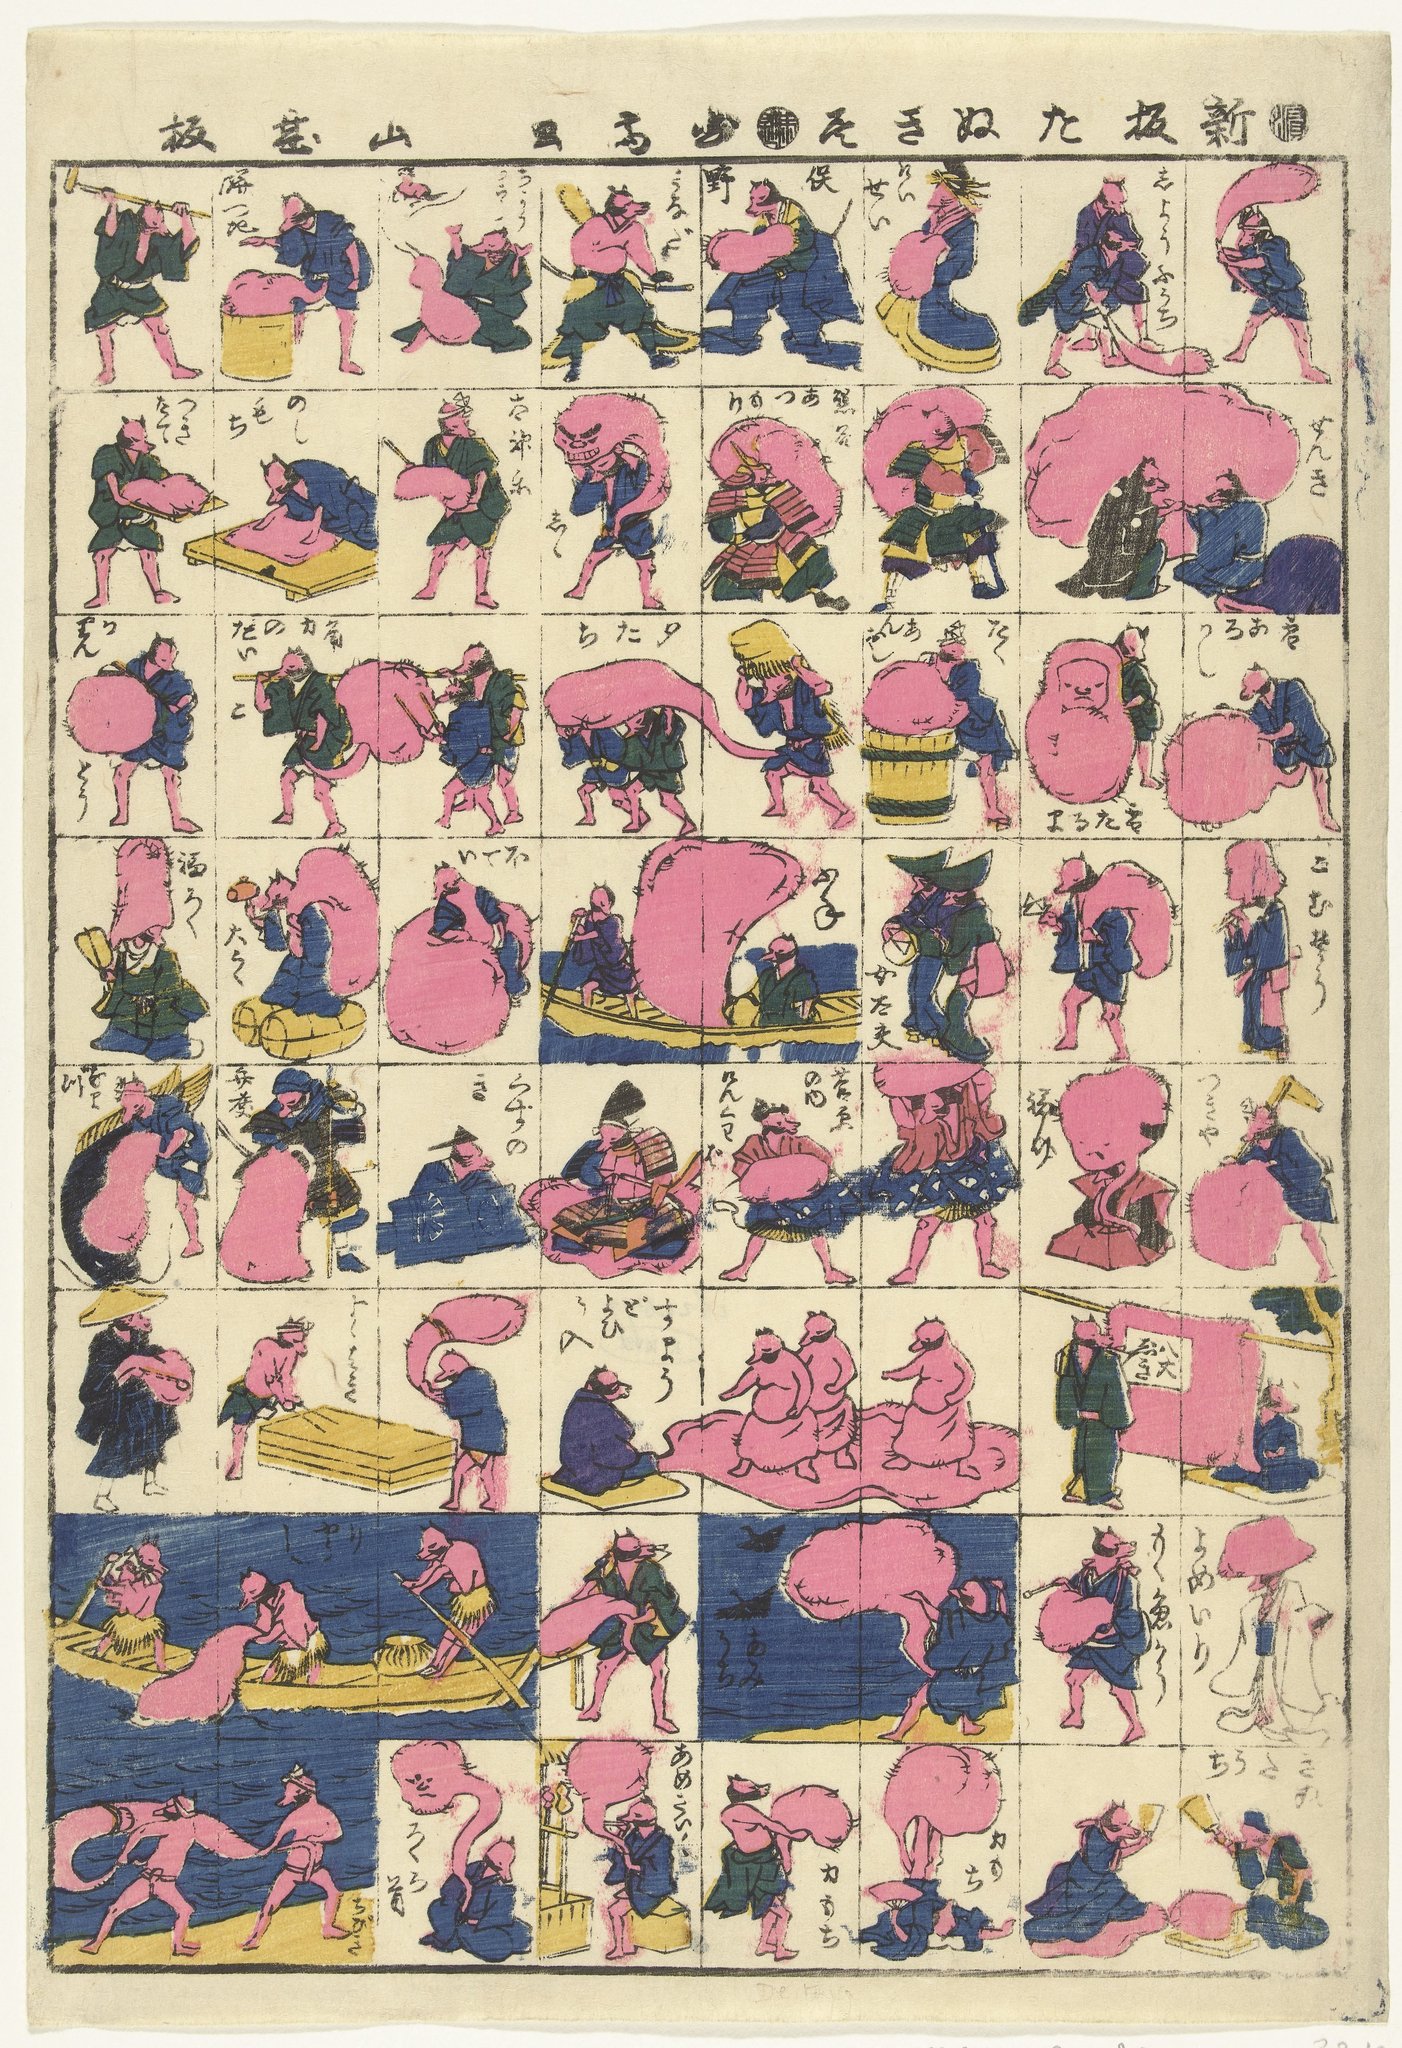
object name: print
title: Vossen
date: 1849-1853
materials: paper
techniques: woodcut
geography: tokyo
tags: beasts of prey, predatory animals: fox, boat propelled by man or animal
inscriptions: collector's mark: Lugt 2228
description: Blad, opgedeeld in 64 vakjes met komische afbeeldingen van vossen die op verschillende manieren hun staart proberen niet te laten opvallen.